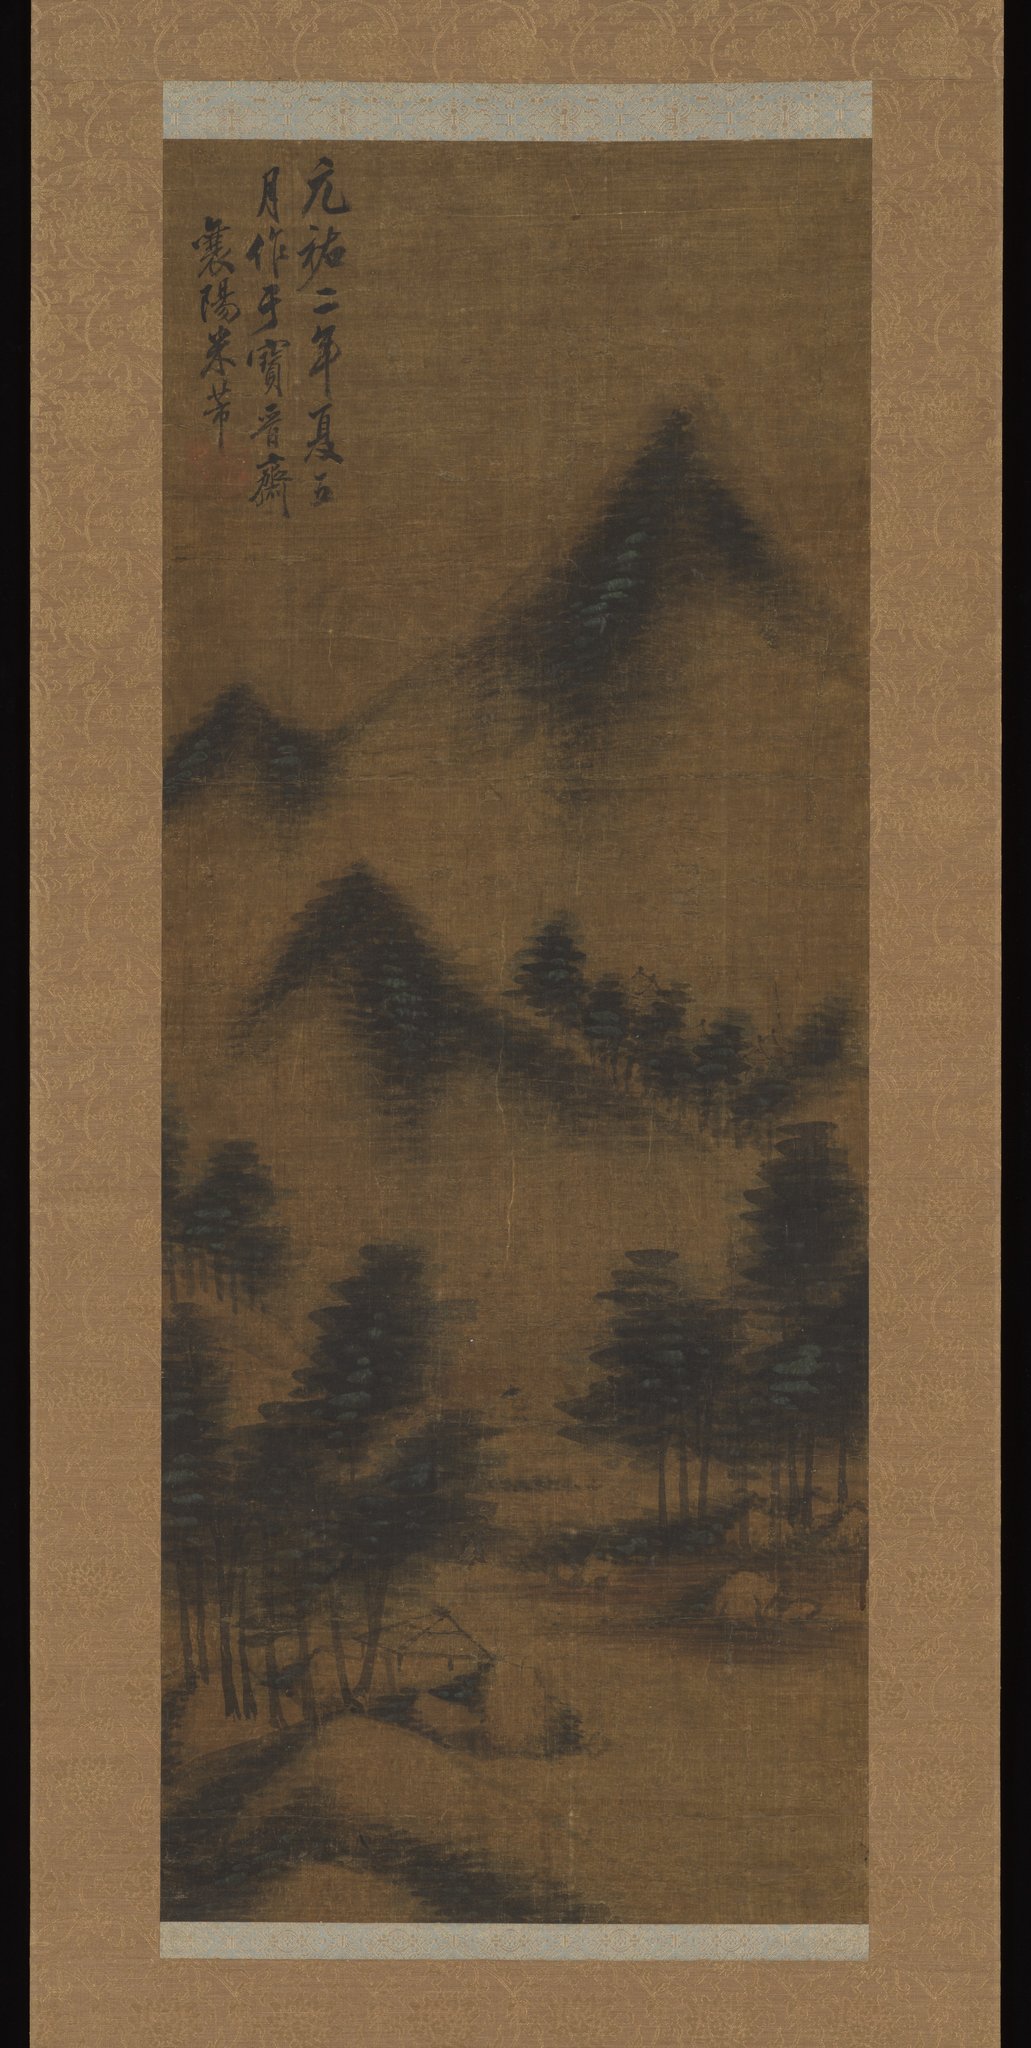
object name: hanging scroll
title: Landscape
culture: chinese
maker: unidentified artist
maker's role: artist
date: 1368-1911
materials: ink, silk